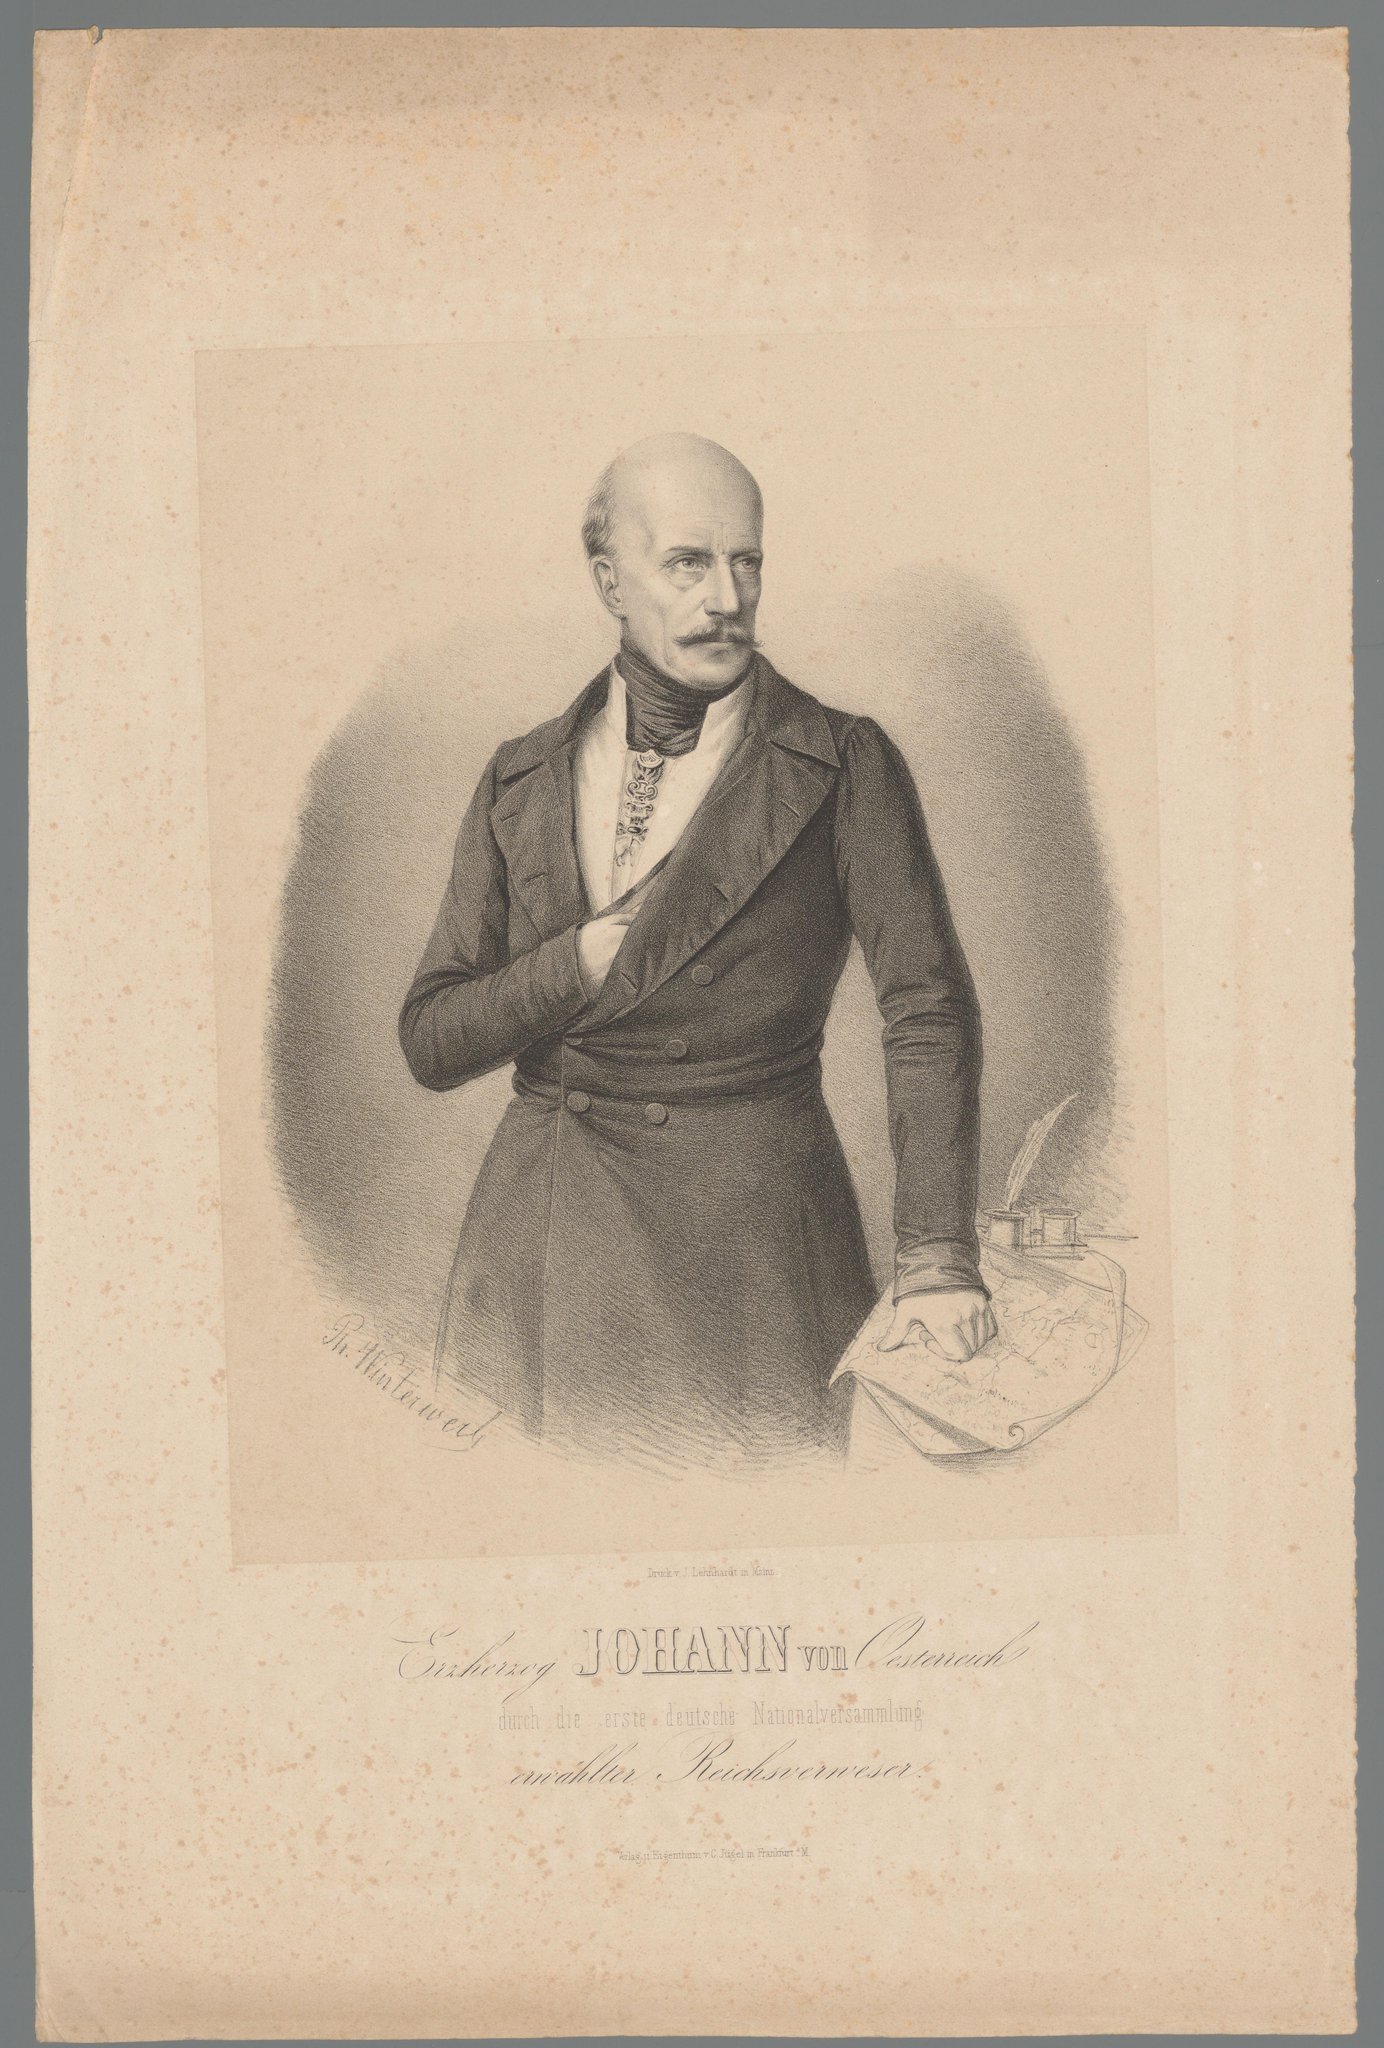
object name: print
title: Portret van Johann, aartshertog van Oostenrijk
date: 1848-1855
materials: paper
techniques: tone lithography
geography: mainz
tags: maps, atlases, hand on breast (or stomach), slipped into opening of vestment, adult man, historical persons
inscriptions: collector's mark: Lugt 2228